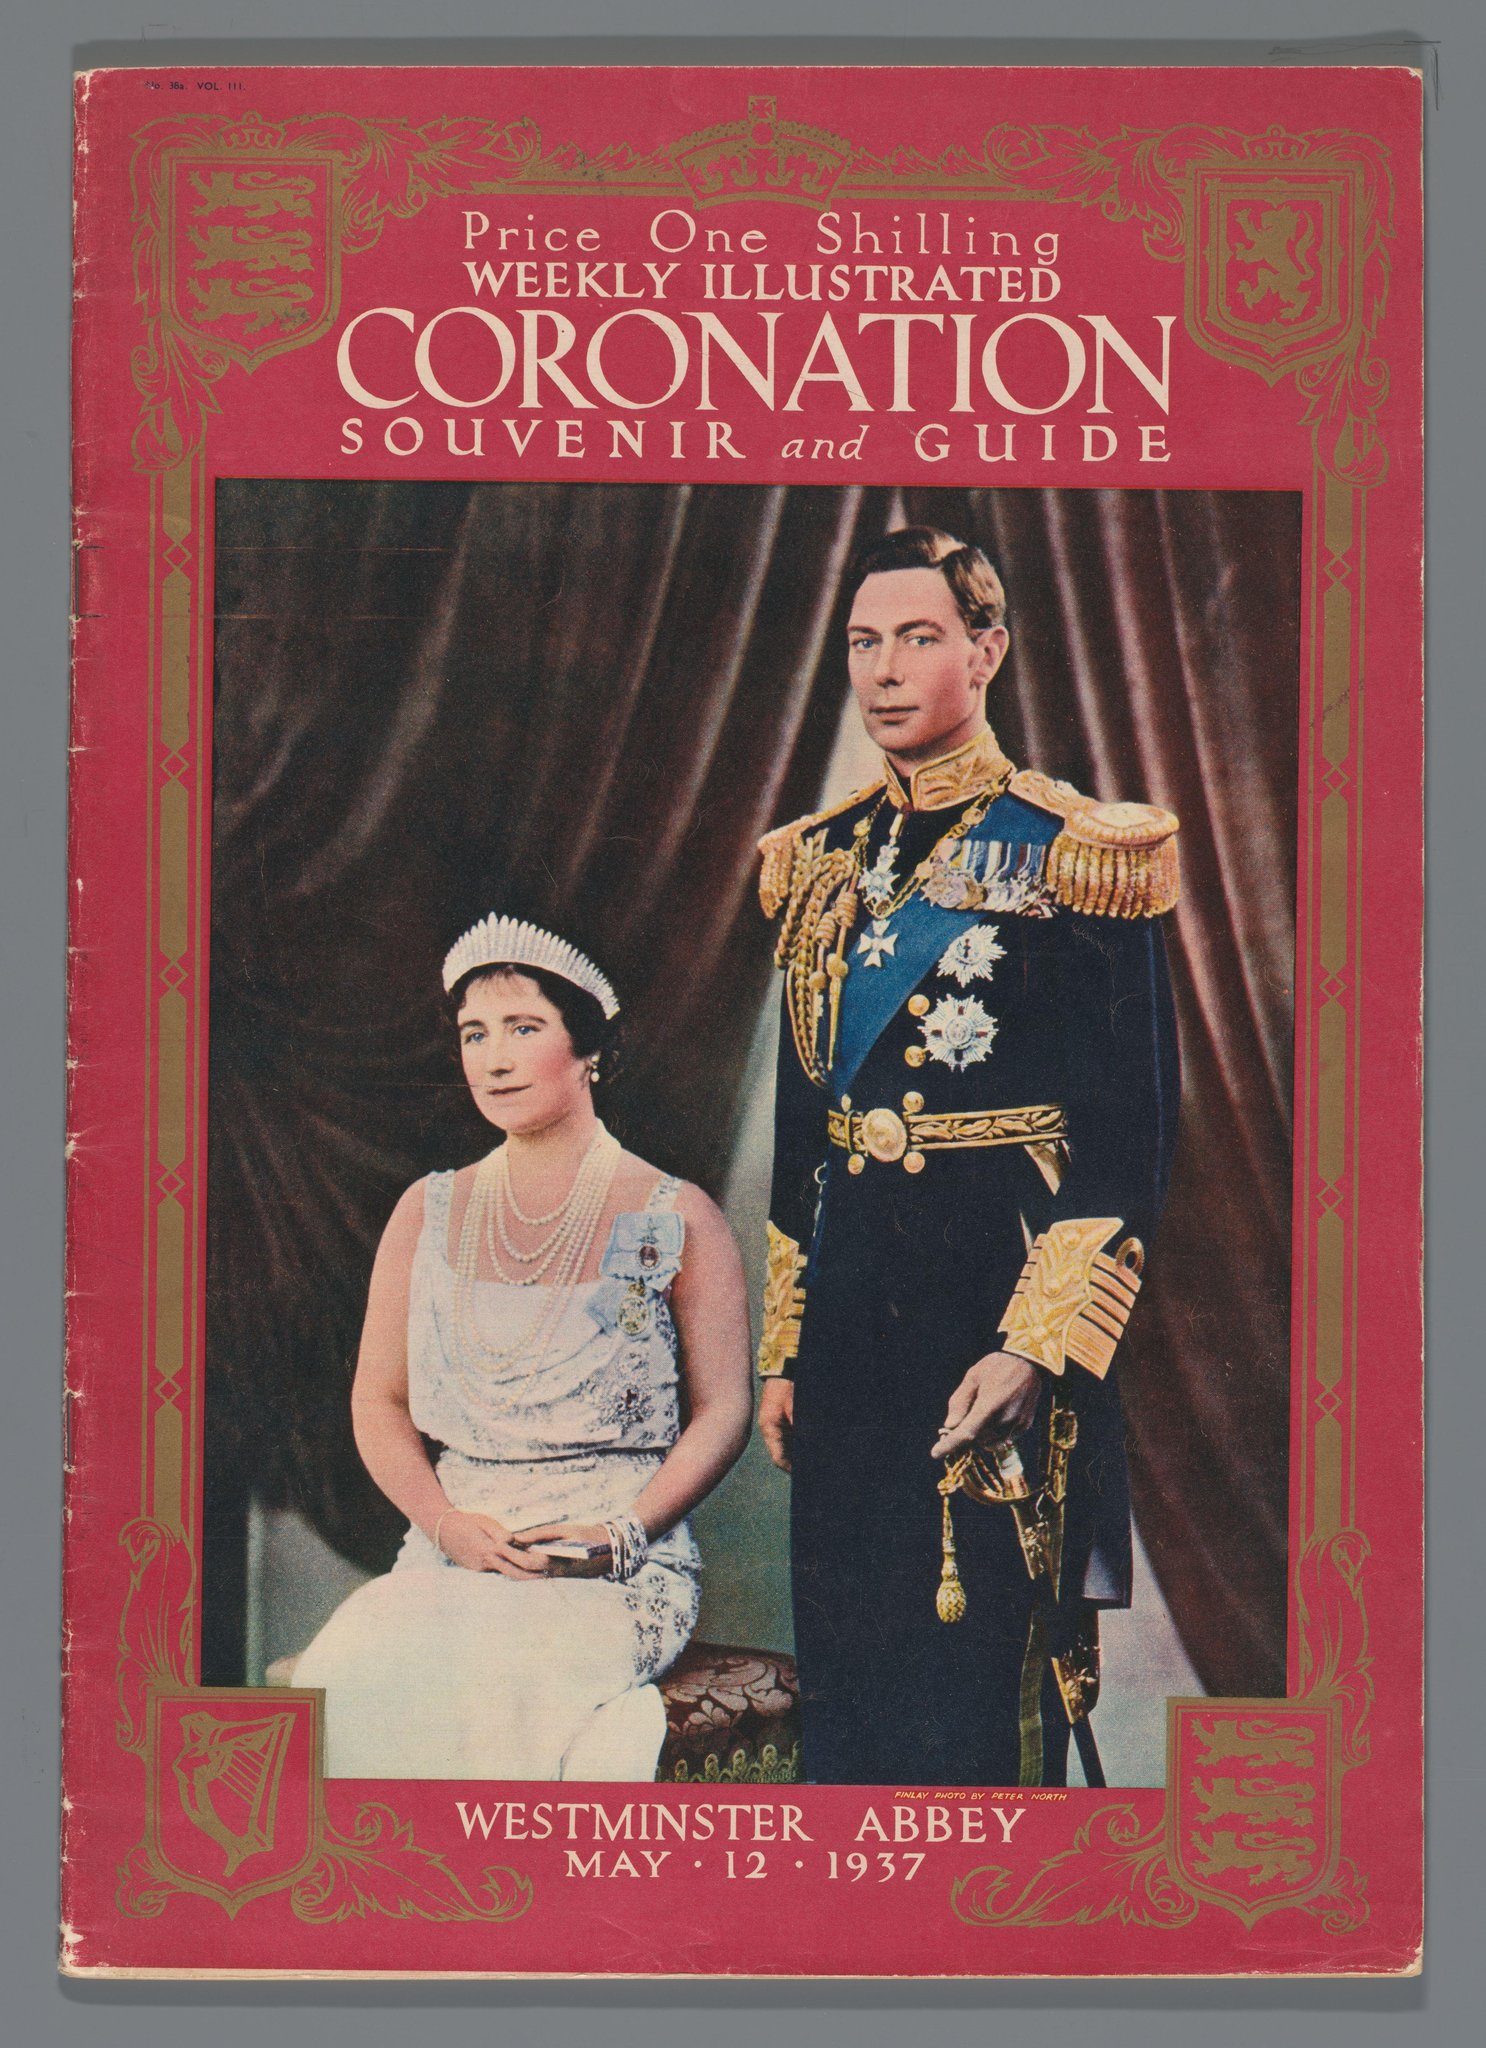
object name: print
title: Weekly Illustrated Coronation souvenir and guide / Westminster Abbey May. 12. 1937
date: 1937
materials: paper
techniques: printed materials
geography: london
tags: coronation of a ruler, london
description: Souvenir tijdschrift ter gelegenheid van de kroning van de Britse koning George VI in Westminster Abbey op 12 mei 1937.